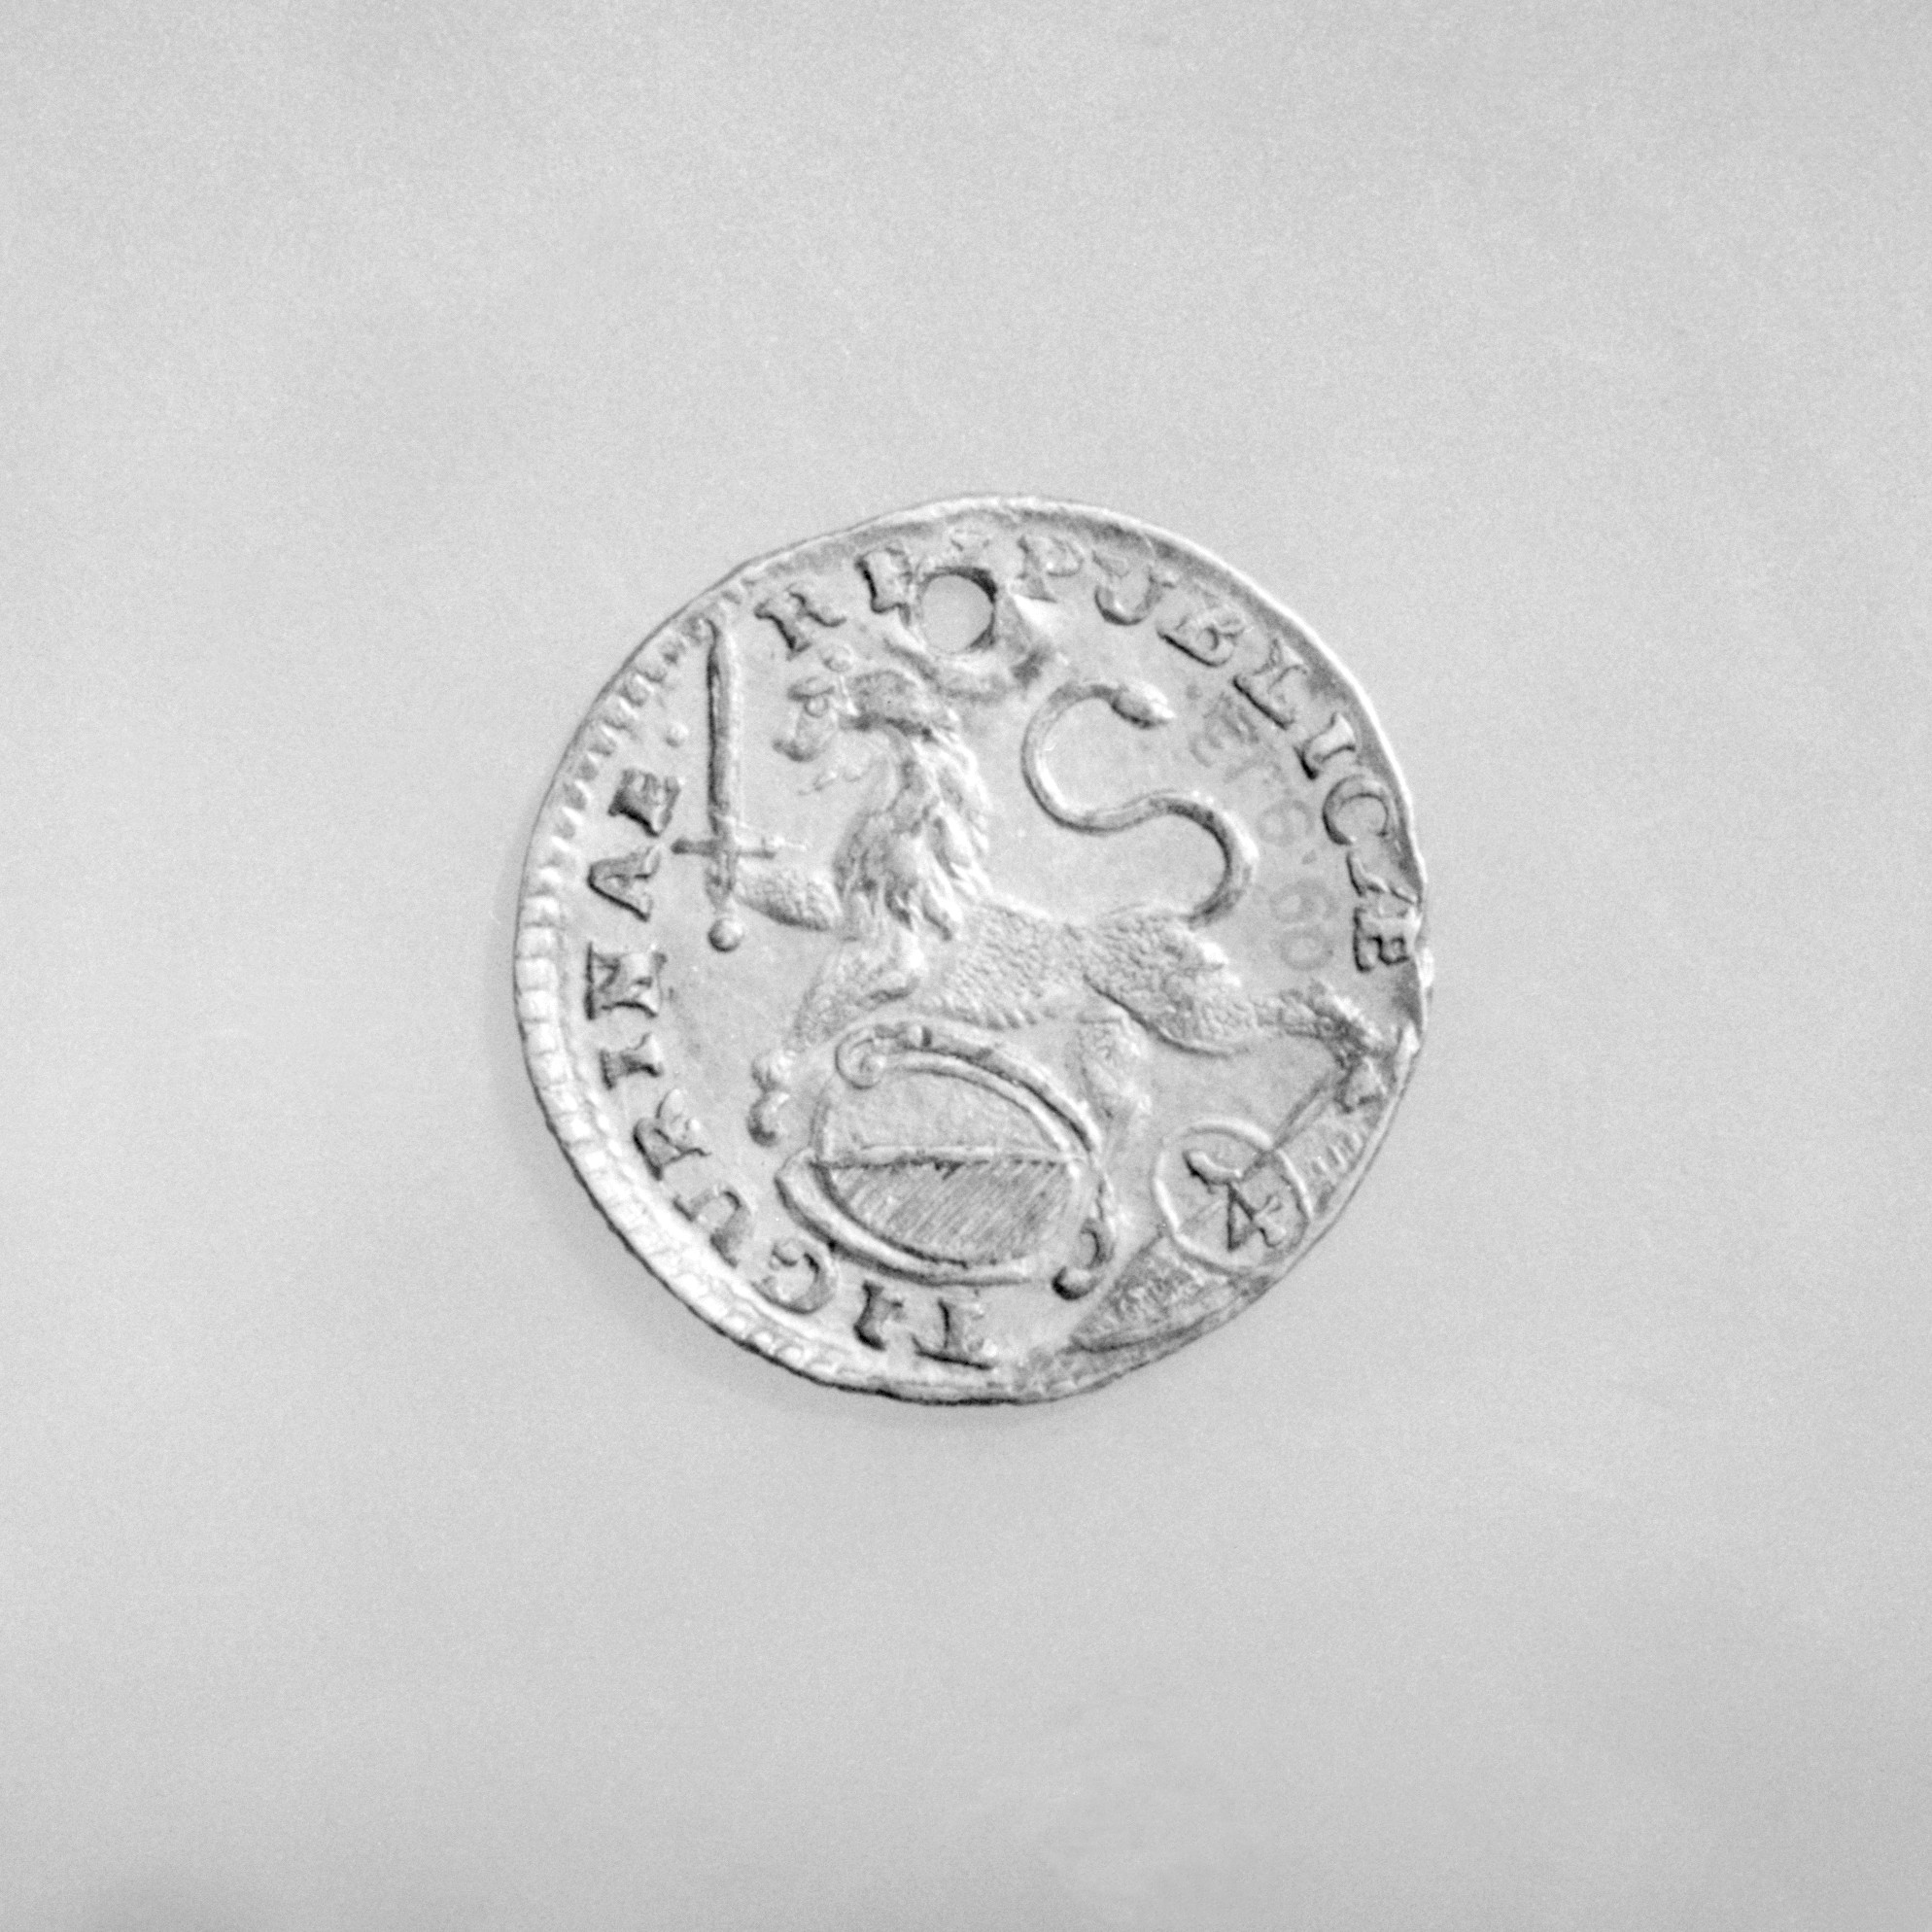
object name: pistole 1 4 ducat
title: Pistole (1/4 ducat) of the Canton of Zurich, Switzerland, 1751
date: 1751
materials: gold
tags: swords,lions